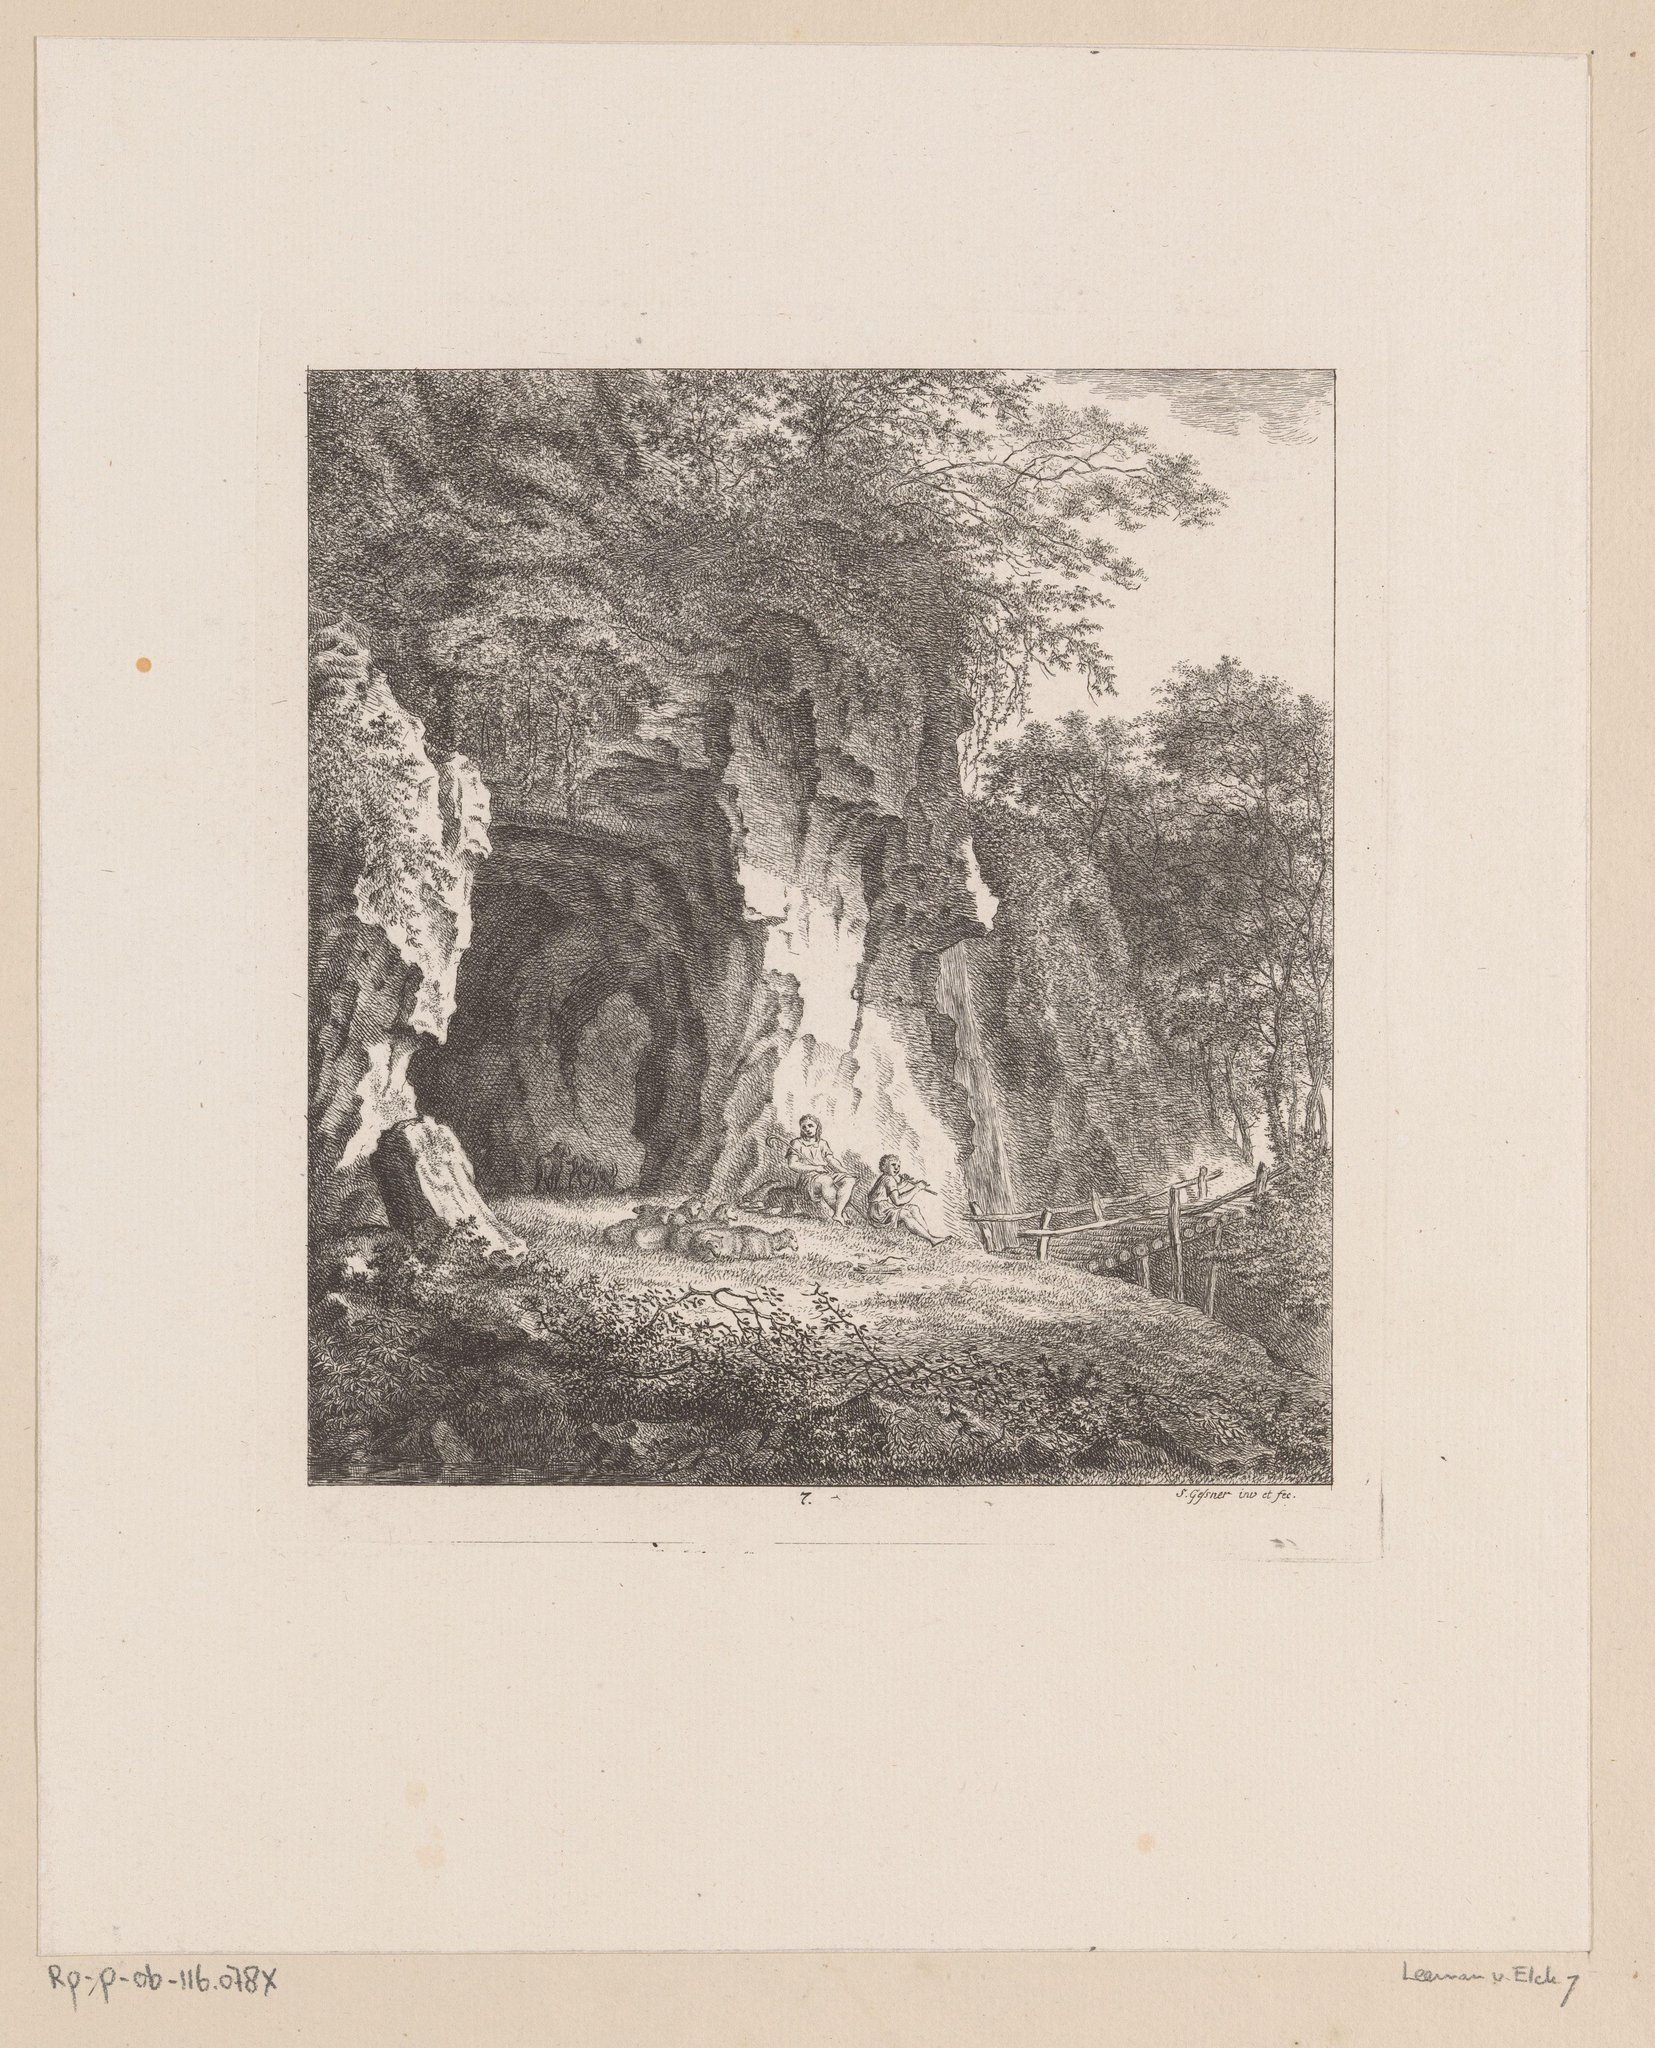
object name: print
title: X Paysages dédiés A Mr. Watelet Auteur du Poême sur l'Art de Peindre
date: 1764-1765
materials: paper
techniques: etching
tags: herding, herdsman, herdswoman, shepherd, shepherdess, cowherd, etc., sheep, cave, grotto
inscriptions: collector's mark: Lugt 240